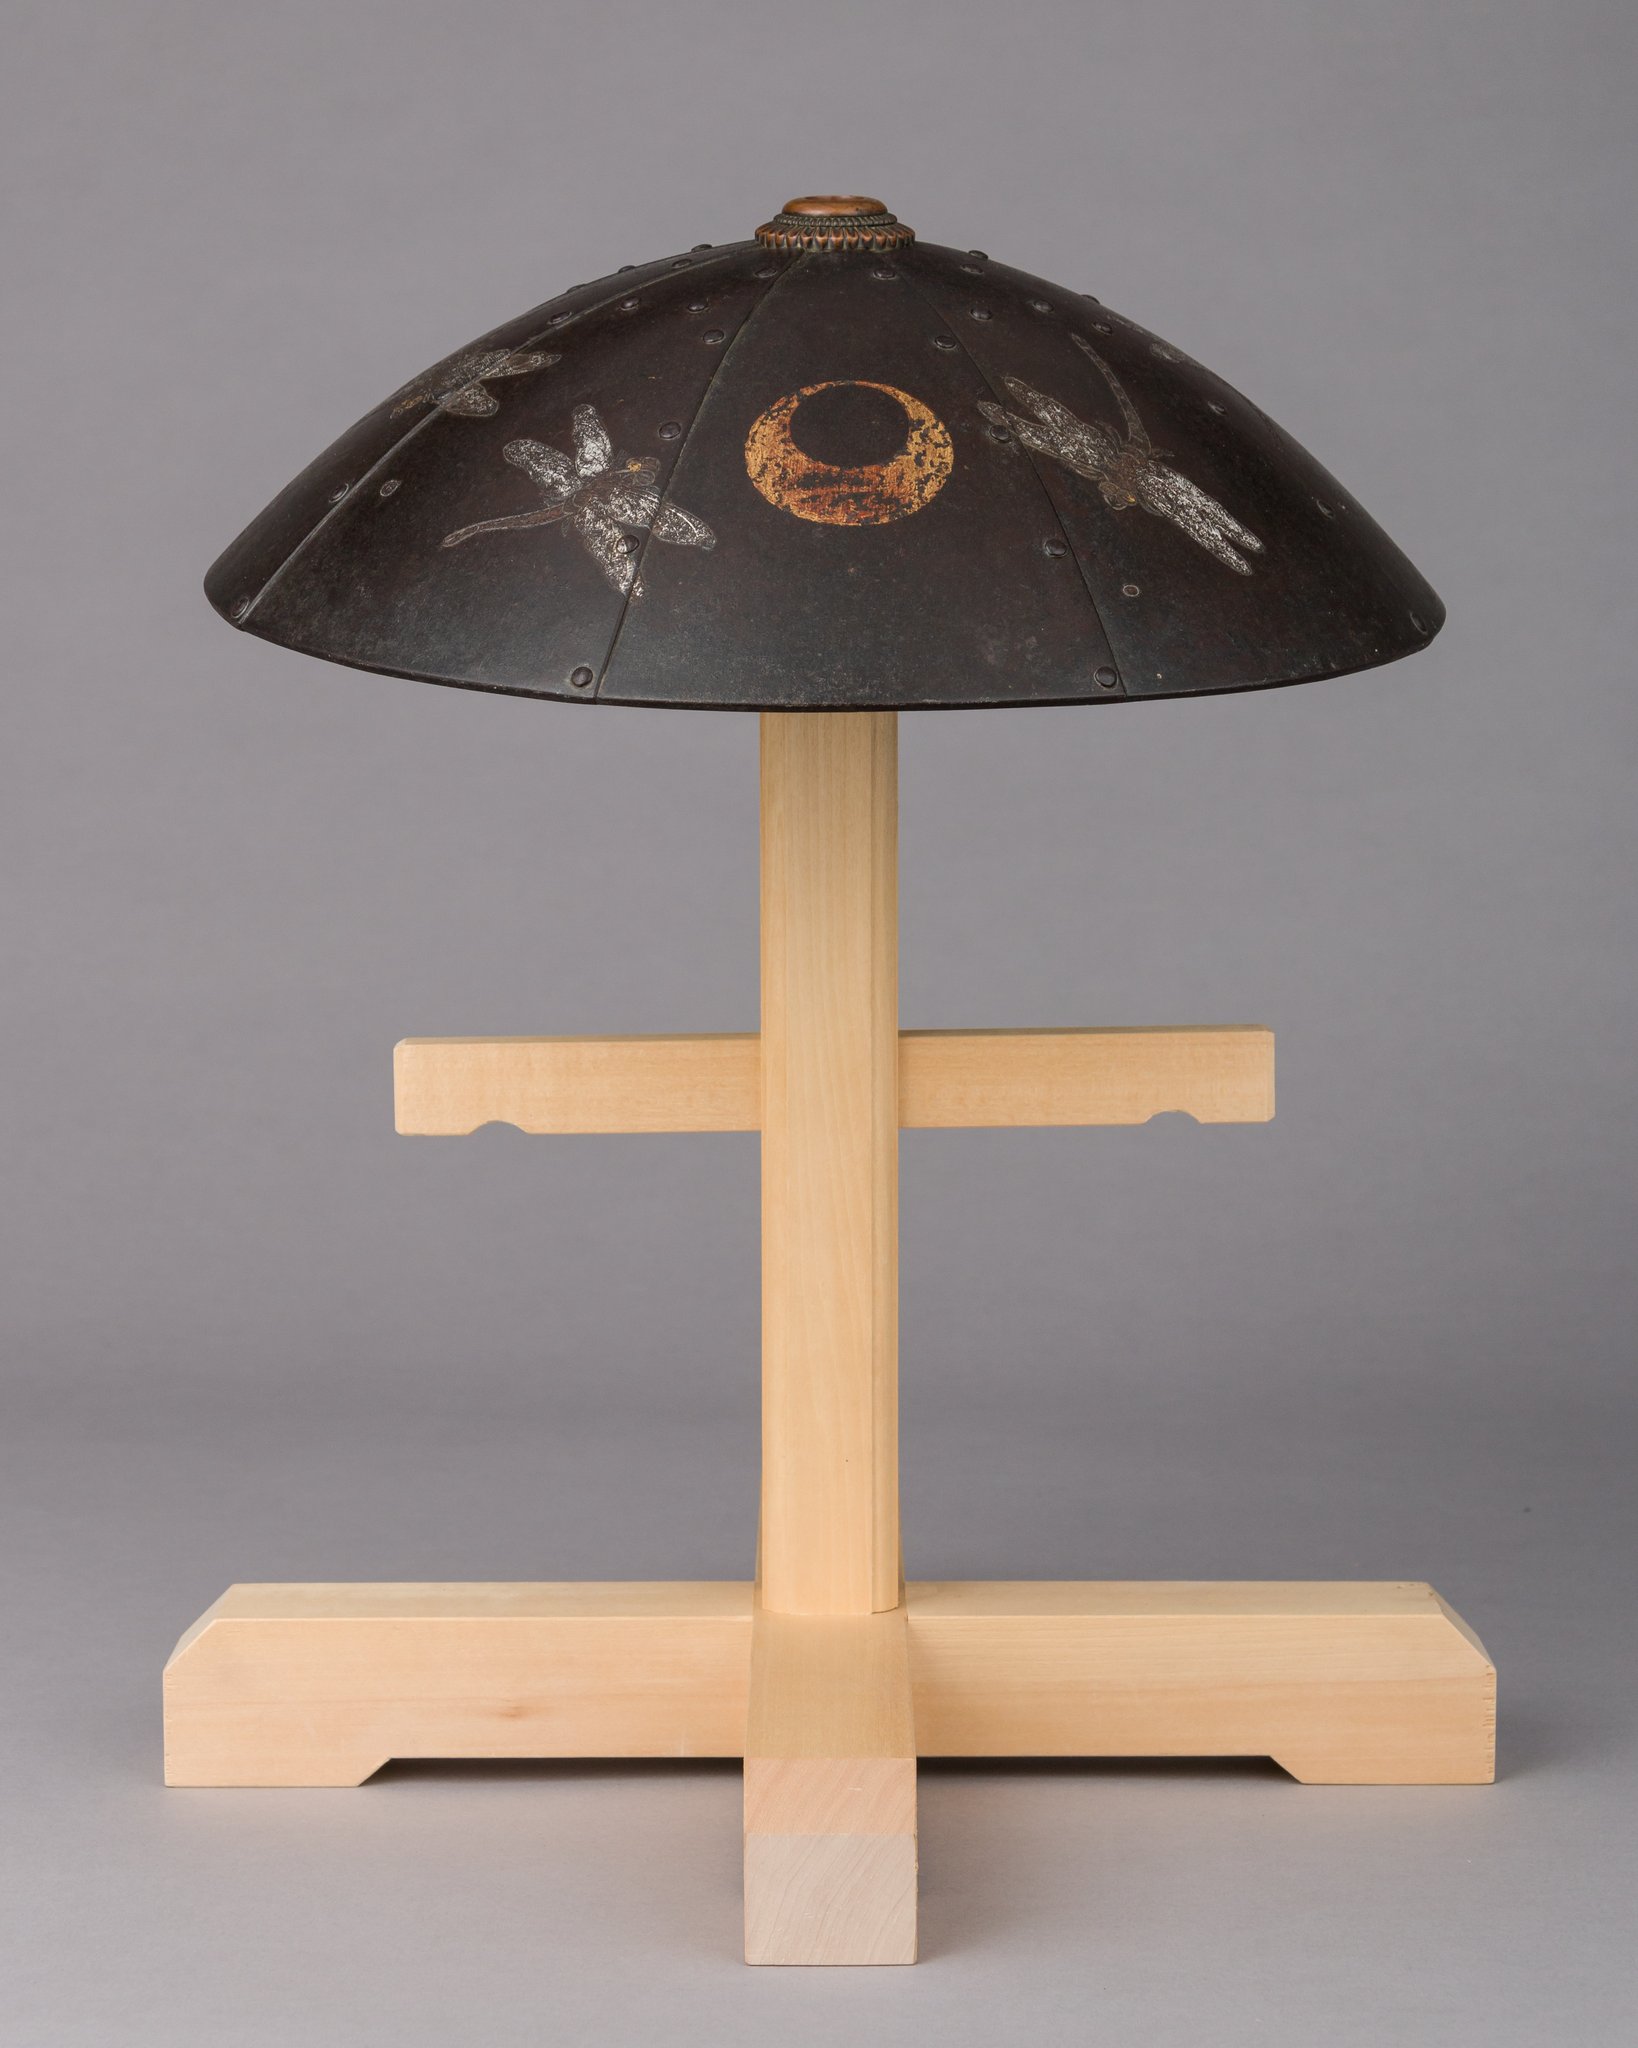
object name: war hat jingasa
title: War Hat (Jingasa) of the Ogasawara Family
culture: japanese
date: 1767-1833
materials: copper, gold, iron, lacquer, silver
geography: japan